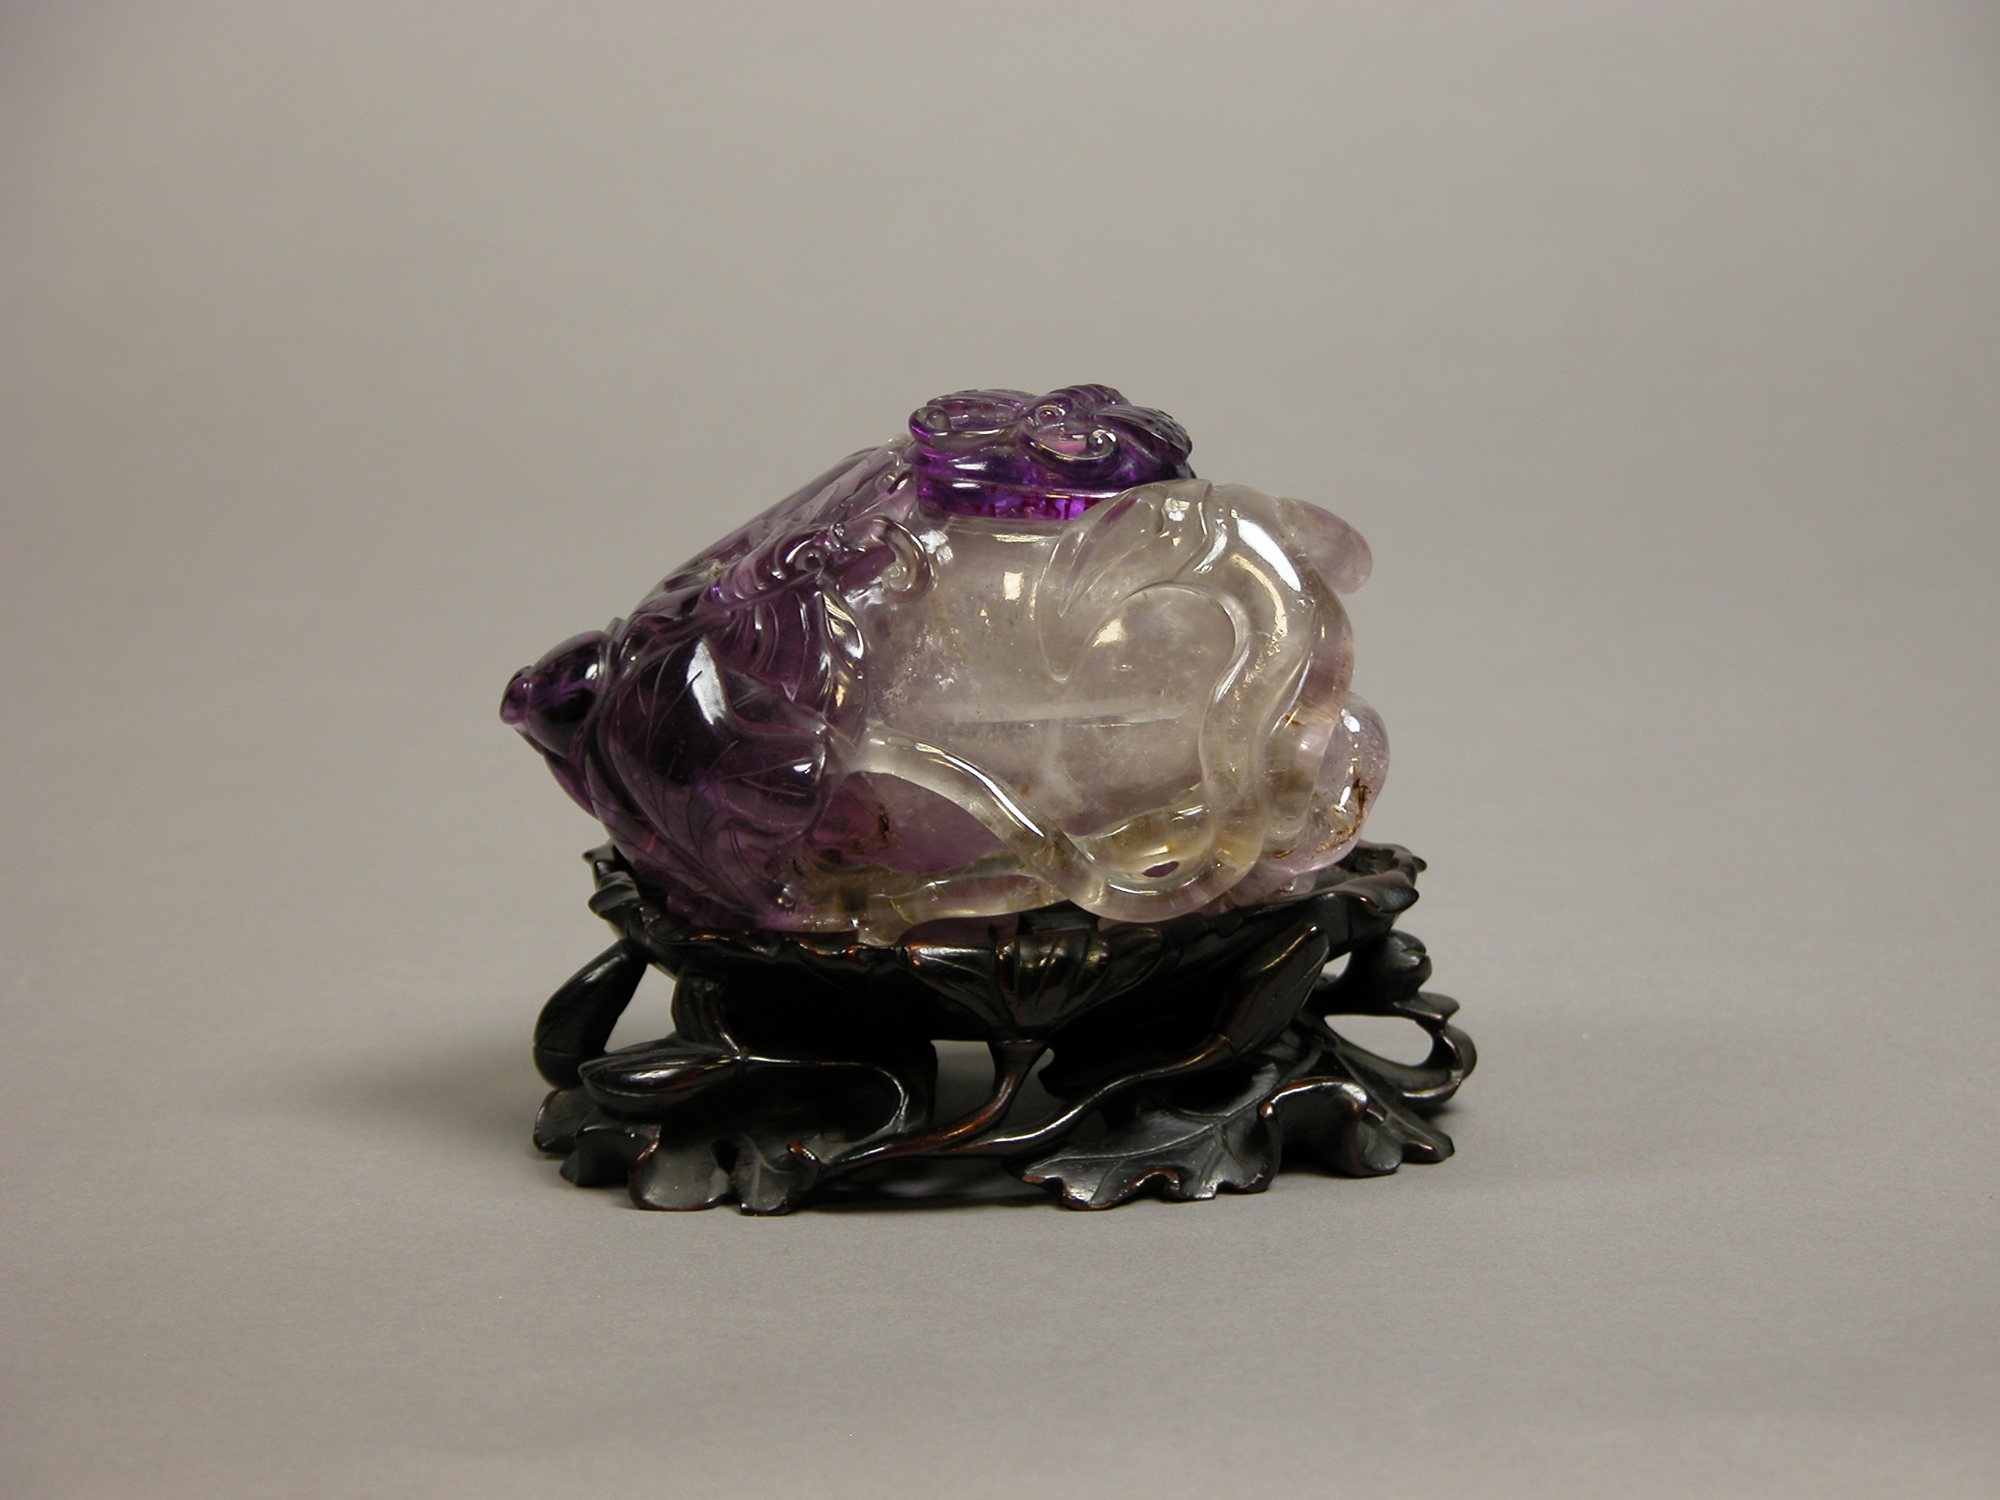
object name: jar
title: Covered box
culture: chinese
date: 1601-1700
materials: gemstone, quartz